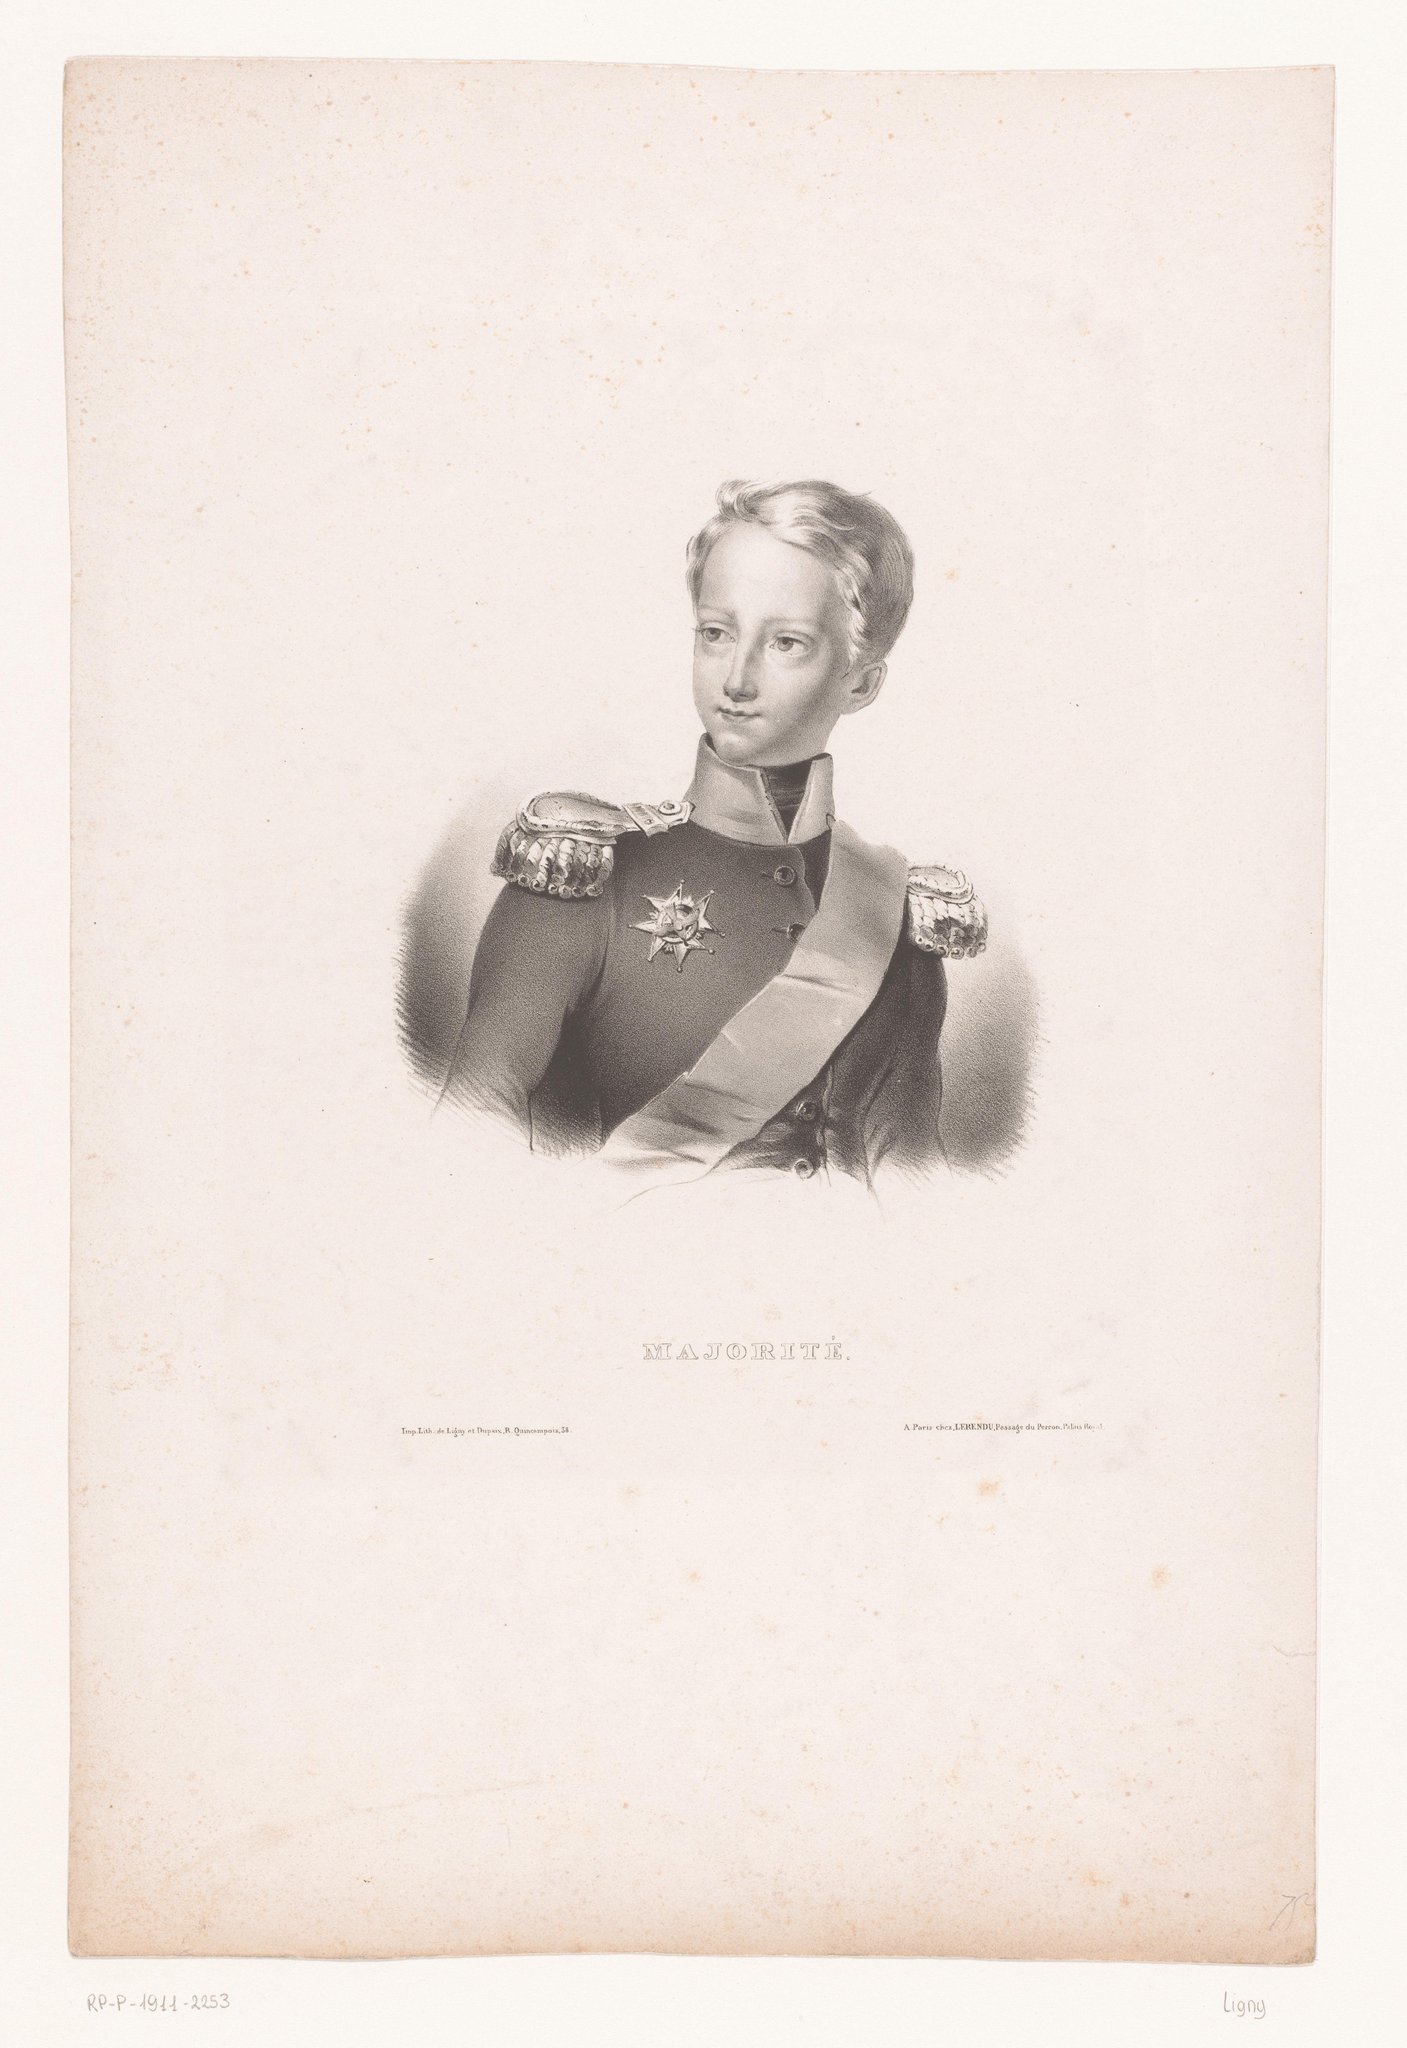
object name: print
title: Majorité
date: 1833-1835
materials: paper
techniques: lithograph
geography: paris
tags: historical persons, youth, adolescent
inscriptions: collector's mark: Lugt 2228